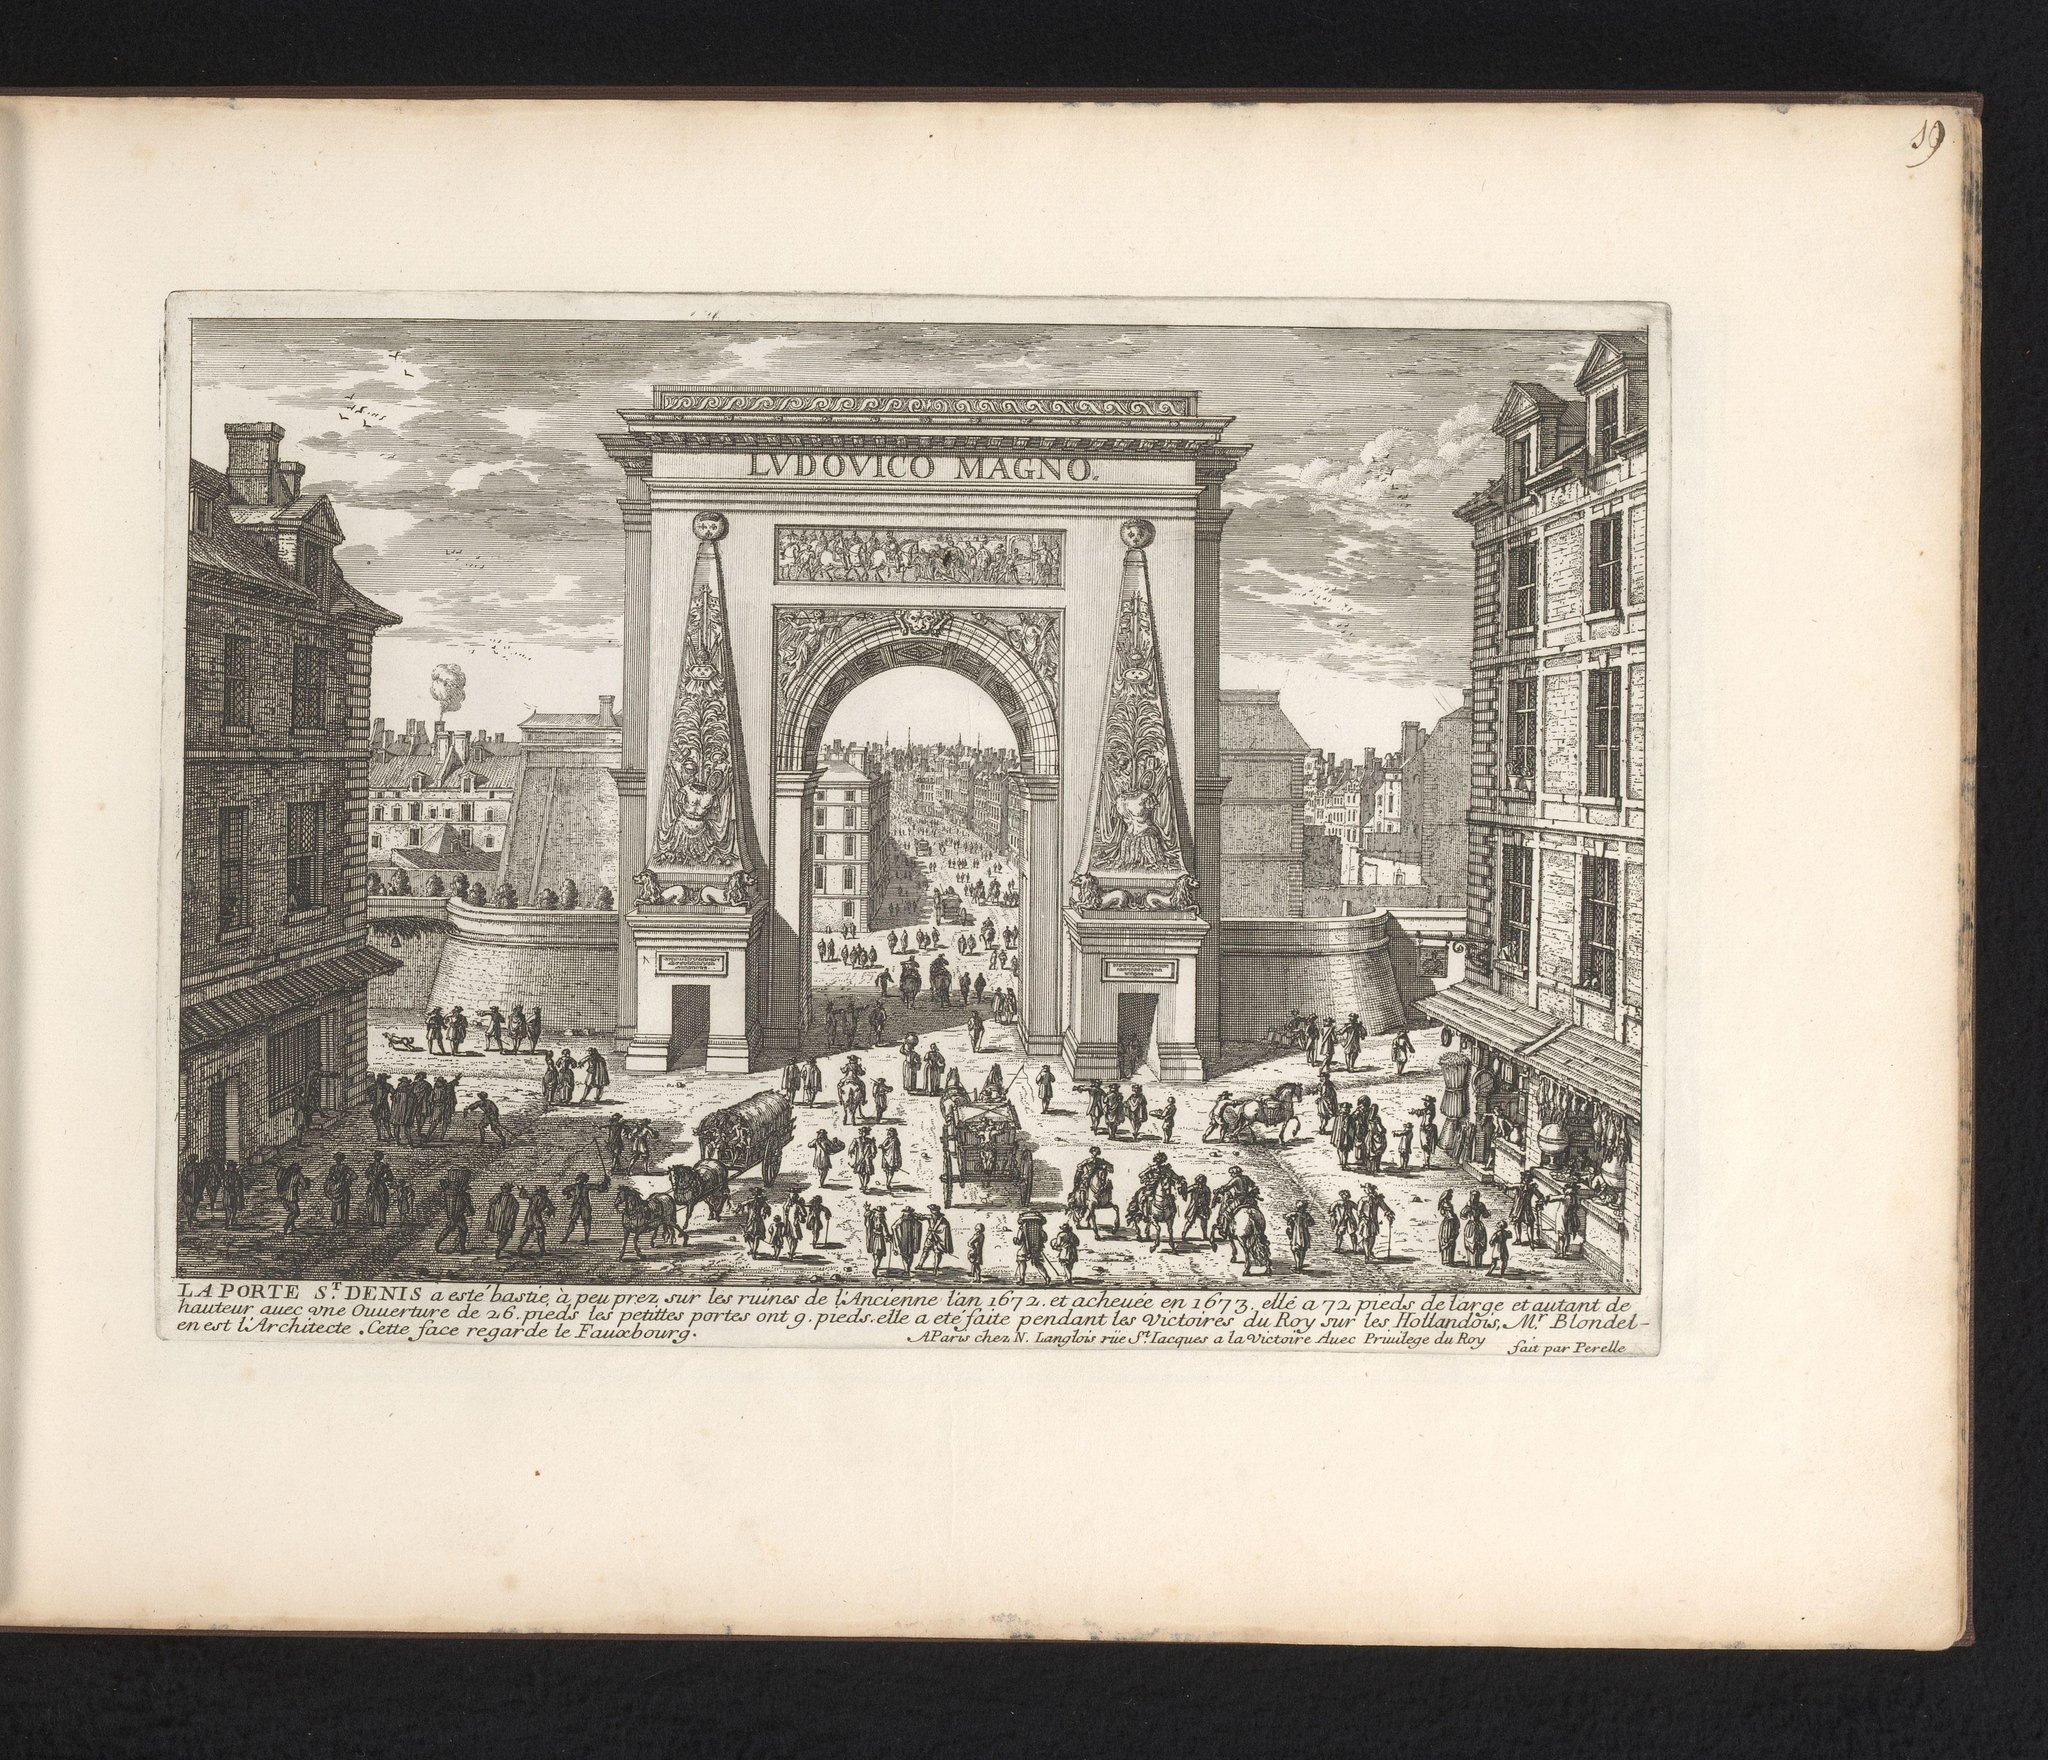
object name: print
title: Stadsgezichten en landschappen in Frankrijk en Italië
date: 1673-1695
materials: paper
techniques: etching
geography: france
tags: city-gate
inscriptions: collector's mark: Lugt 2228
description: Prenten met het signatuur 'Perelle' kunnen zowel door vader Gabriel als door zonen Nicolas en Adam gemaakt zijn. De uitgevers vader en zoon Nicolas Langlois worden allebei vermeld als N. Langlois op hetzelfde adres.